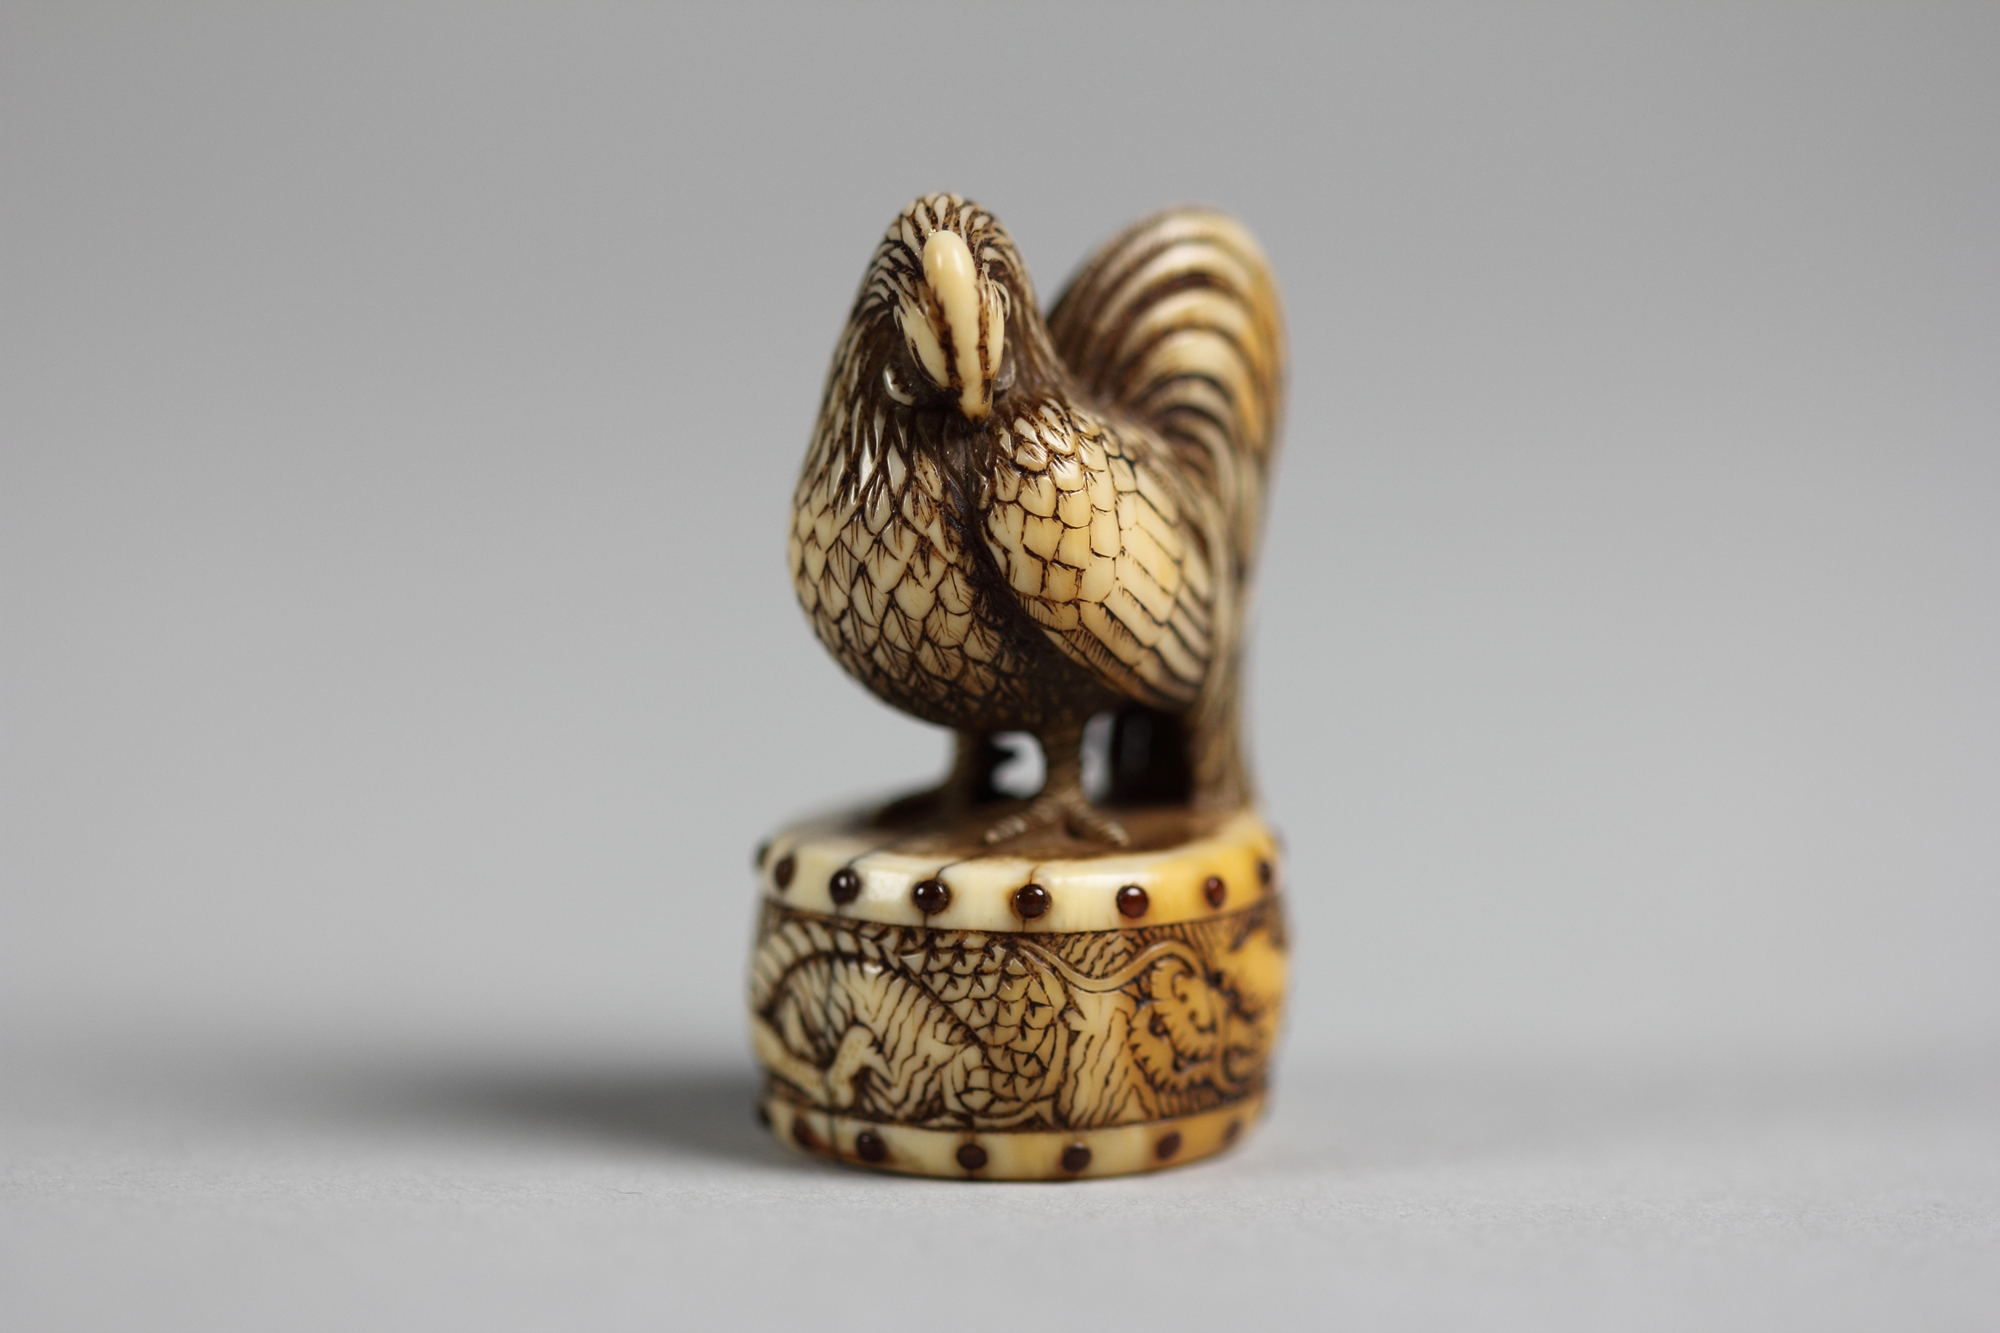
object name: netsuke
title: Netsuke of the Fowl on the Drum of the Wise Emperor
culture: japanese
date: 1801-1900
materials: ivory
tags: birds,drums